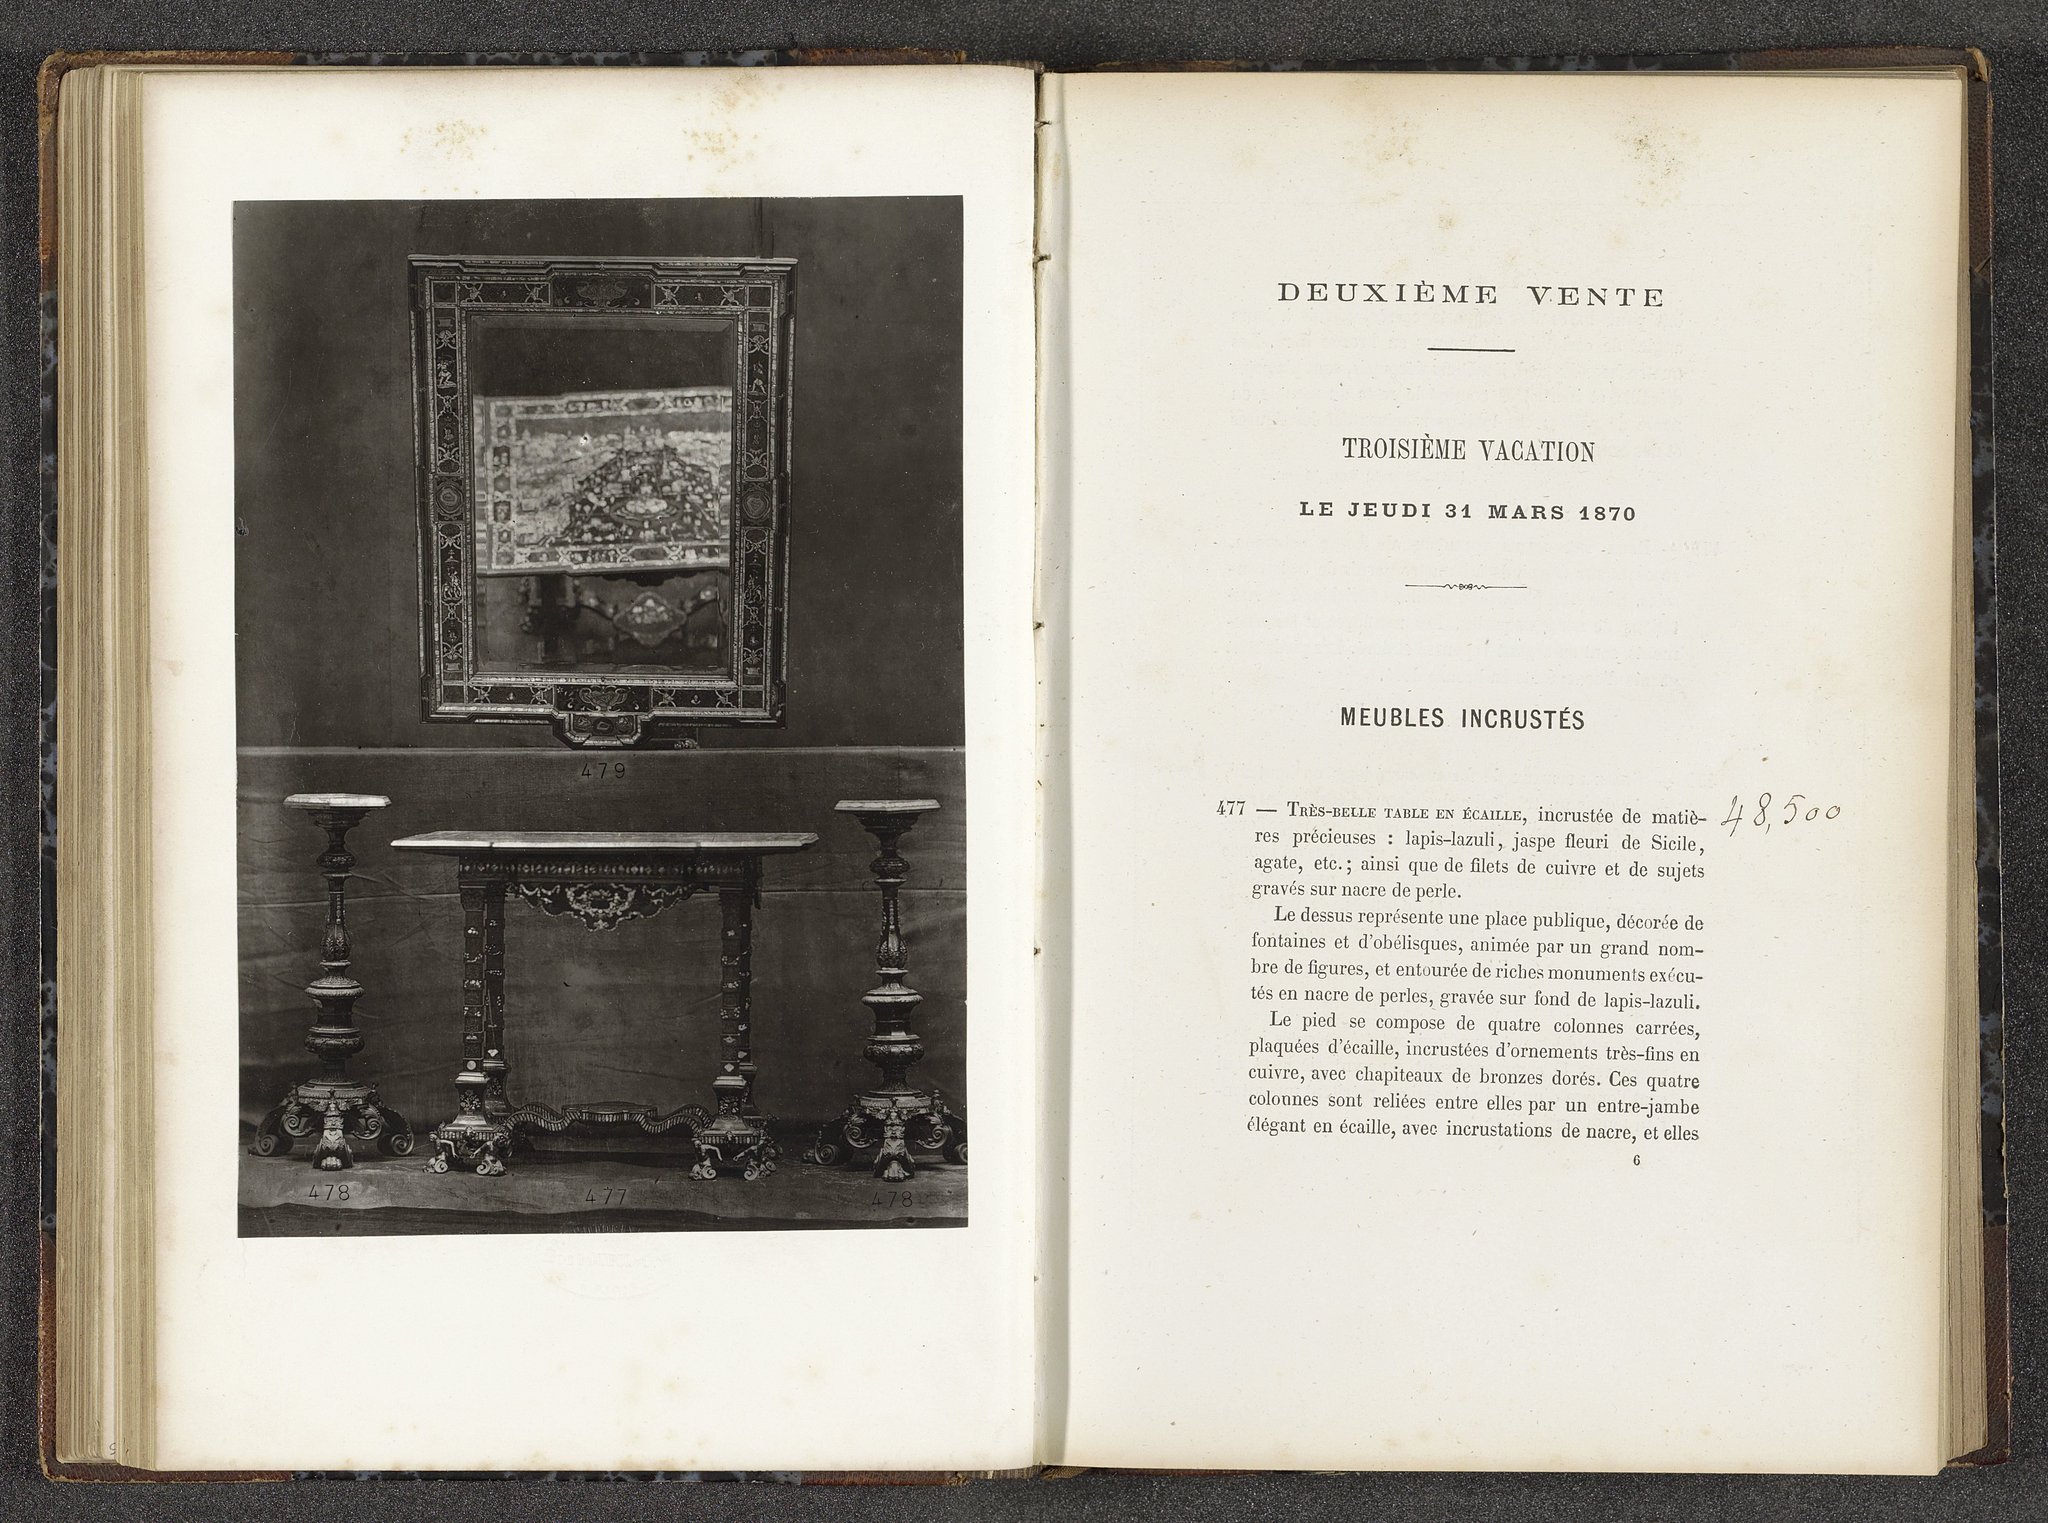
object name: page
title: Tafel, twee kaarsenhouders en een spiegel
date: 1870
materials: paper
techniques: woodburytype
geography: paris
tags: mirror, table, candlestick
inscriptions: number: ‘477 478 479’, name: ‘De Goupil & Cie Imp. Photoglytique Paris’